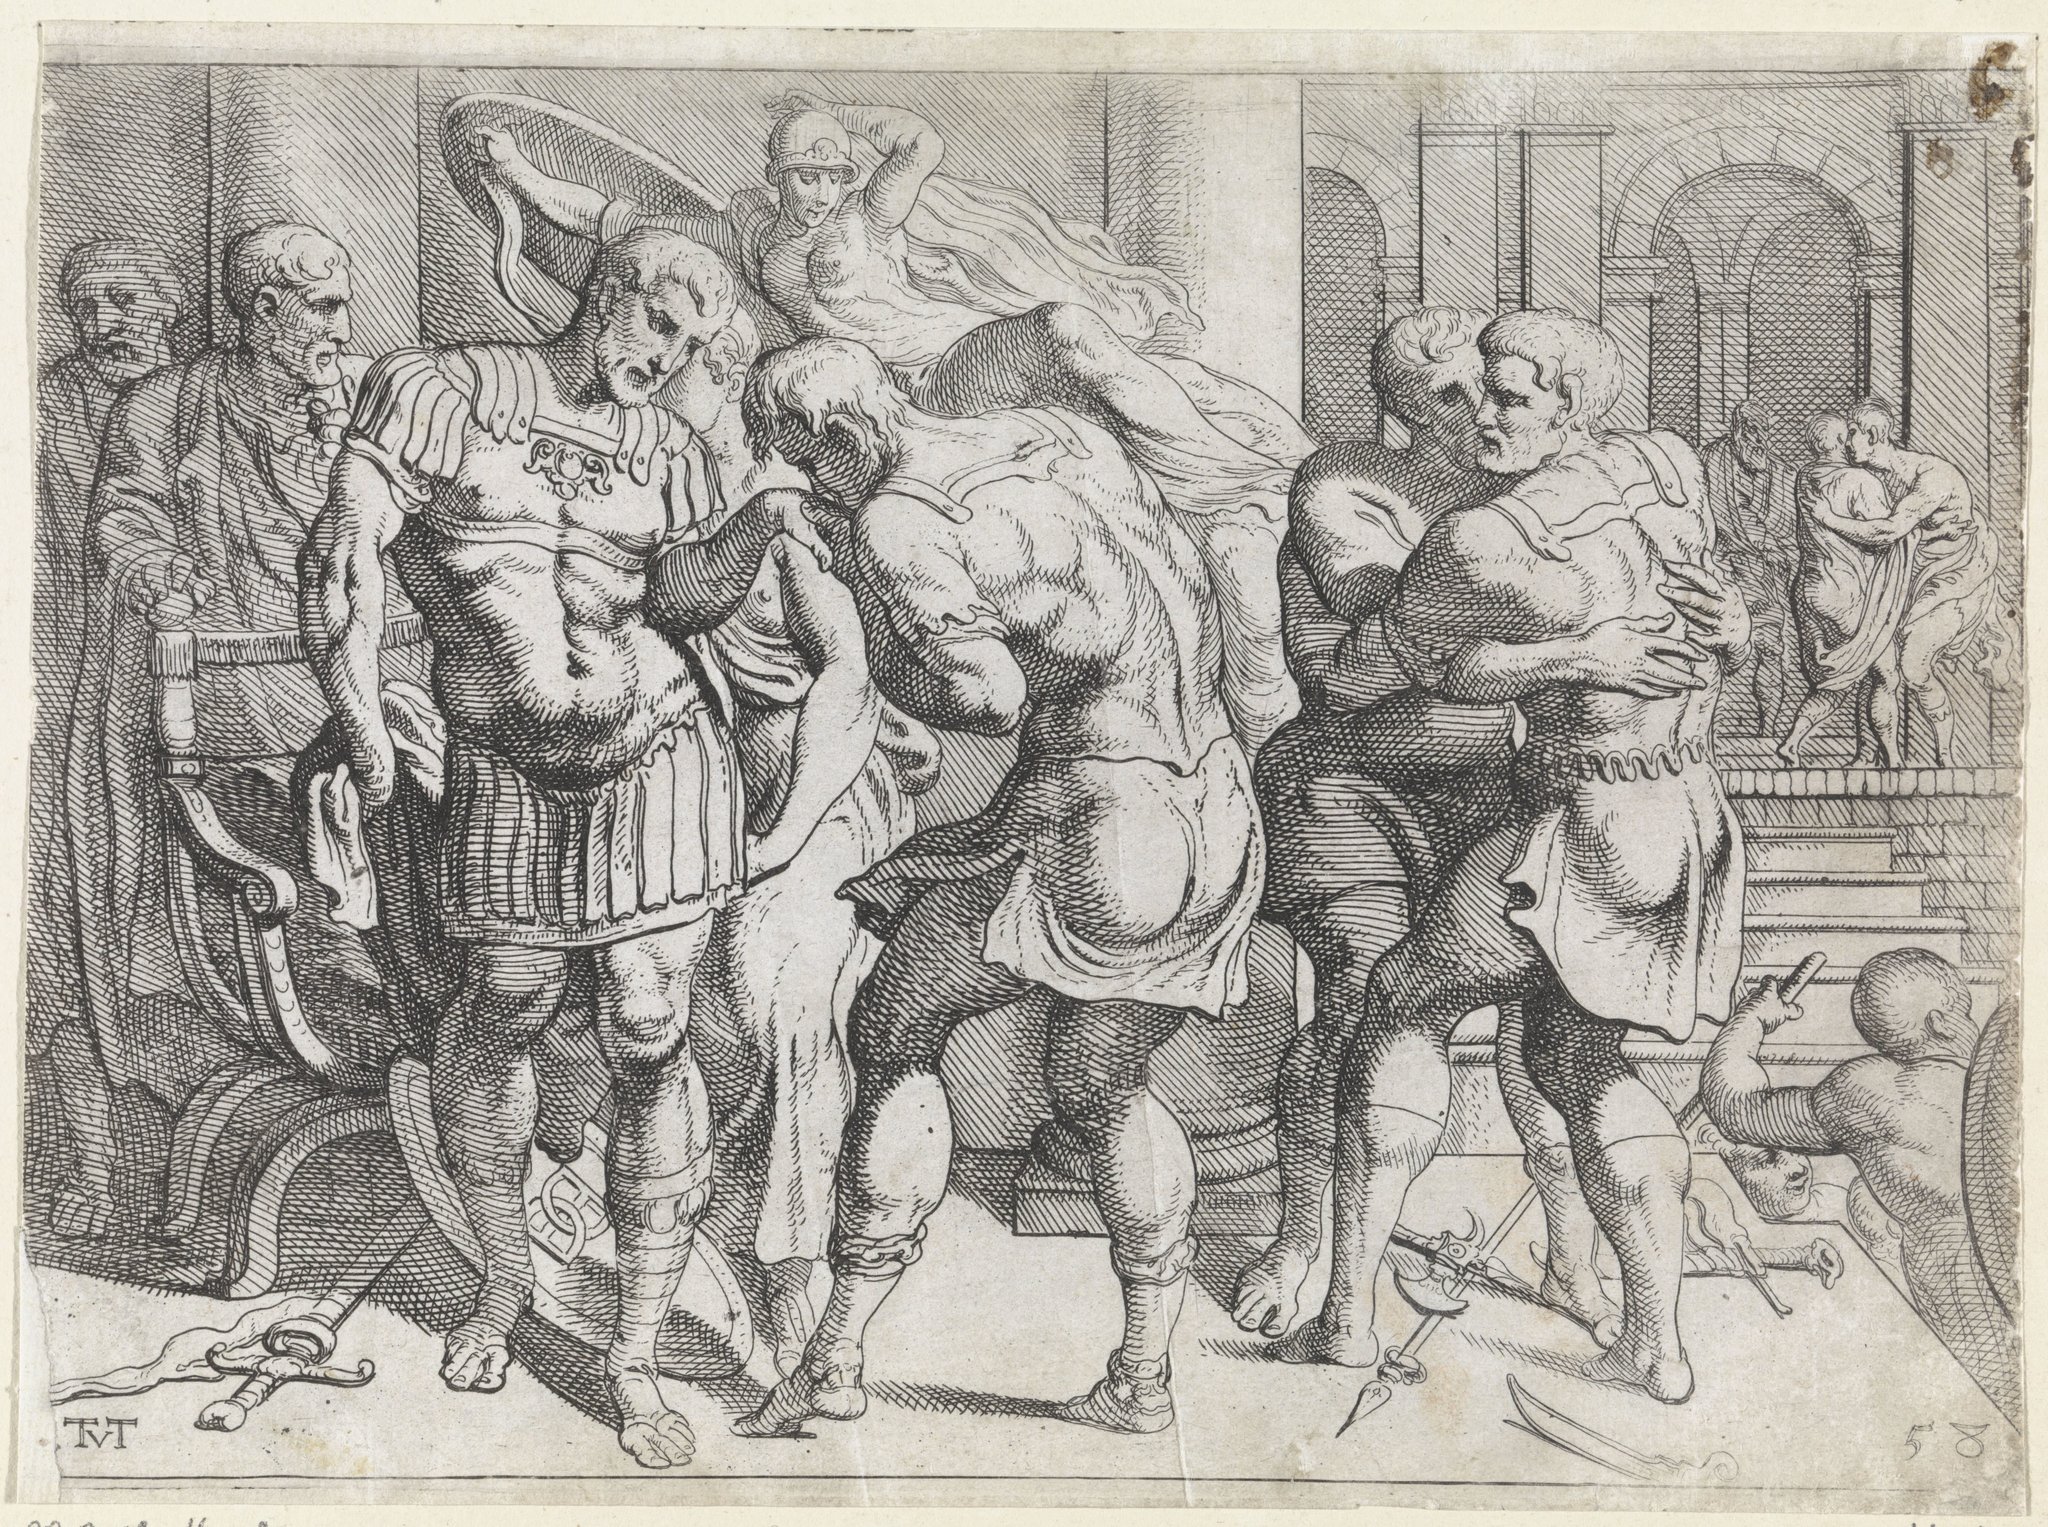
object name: print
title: Verzoening tussen Odysseus en de Ithacaanse rebellen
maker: theodoor van thulden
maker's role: draughtsman, painter, print maker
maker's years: 1606-1669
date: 1632-1633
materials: paper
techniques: engraving, etching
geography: paris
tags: minerva intervenes; reconciliation of ulysses and the ithacan rebels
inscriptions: collector's mark: Lugt 2228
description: Onder toeziend oog van Minerva verzoenen Odysseus en de vijandige Ithacanen zich met elkaar. Zij vallen elkaar in de armen.